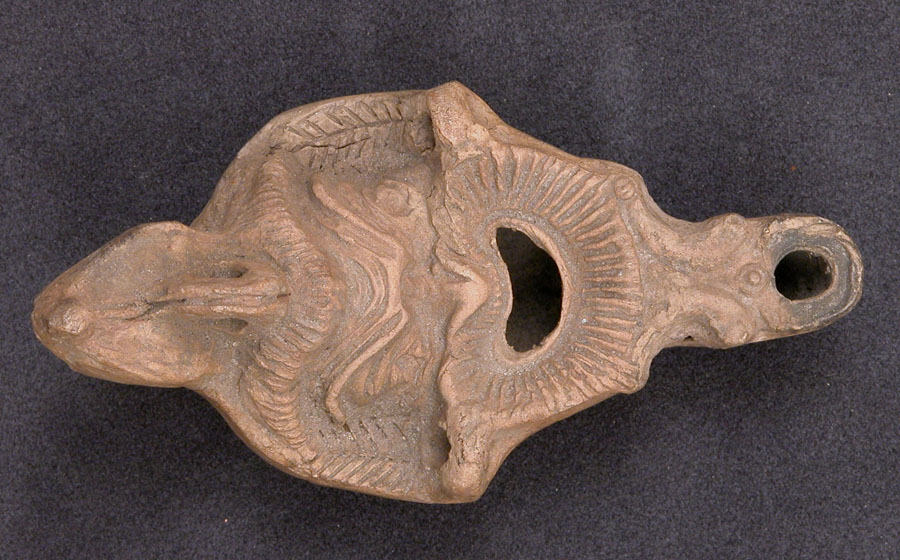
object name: lamp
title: Lamp in the Form of a Mask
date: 100 BCE-100 CE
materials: earthenware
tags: masks